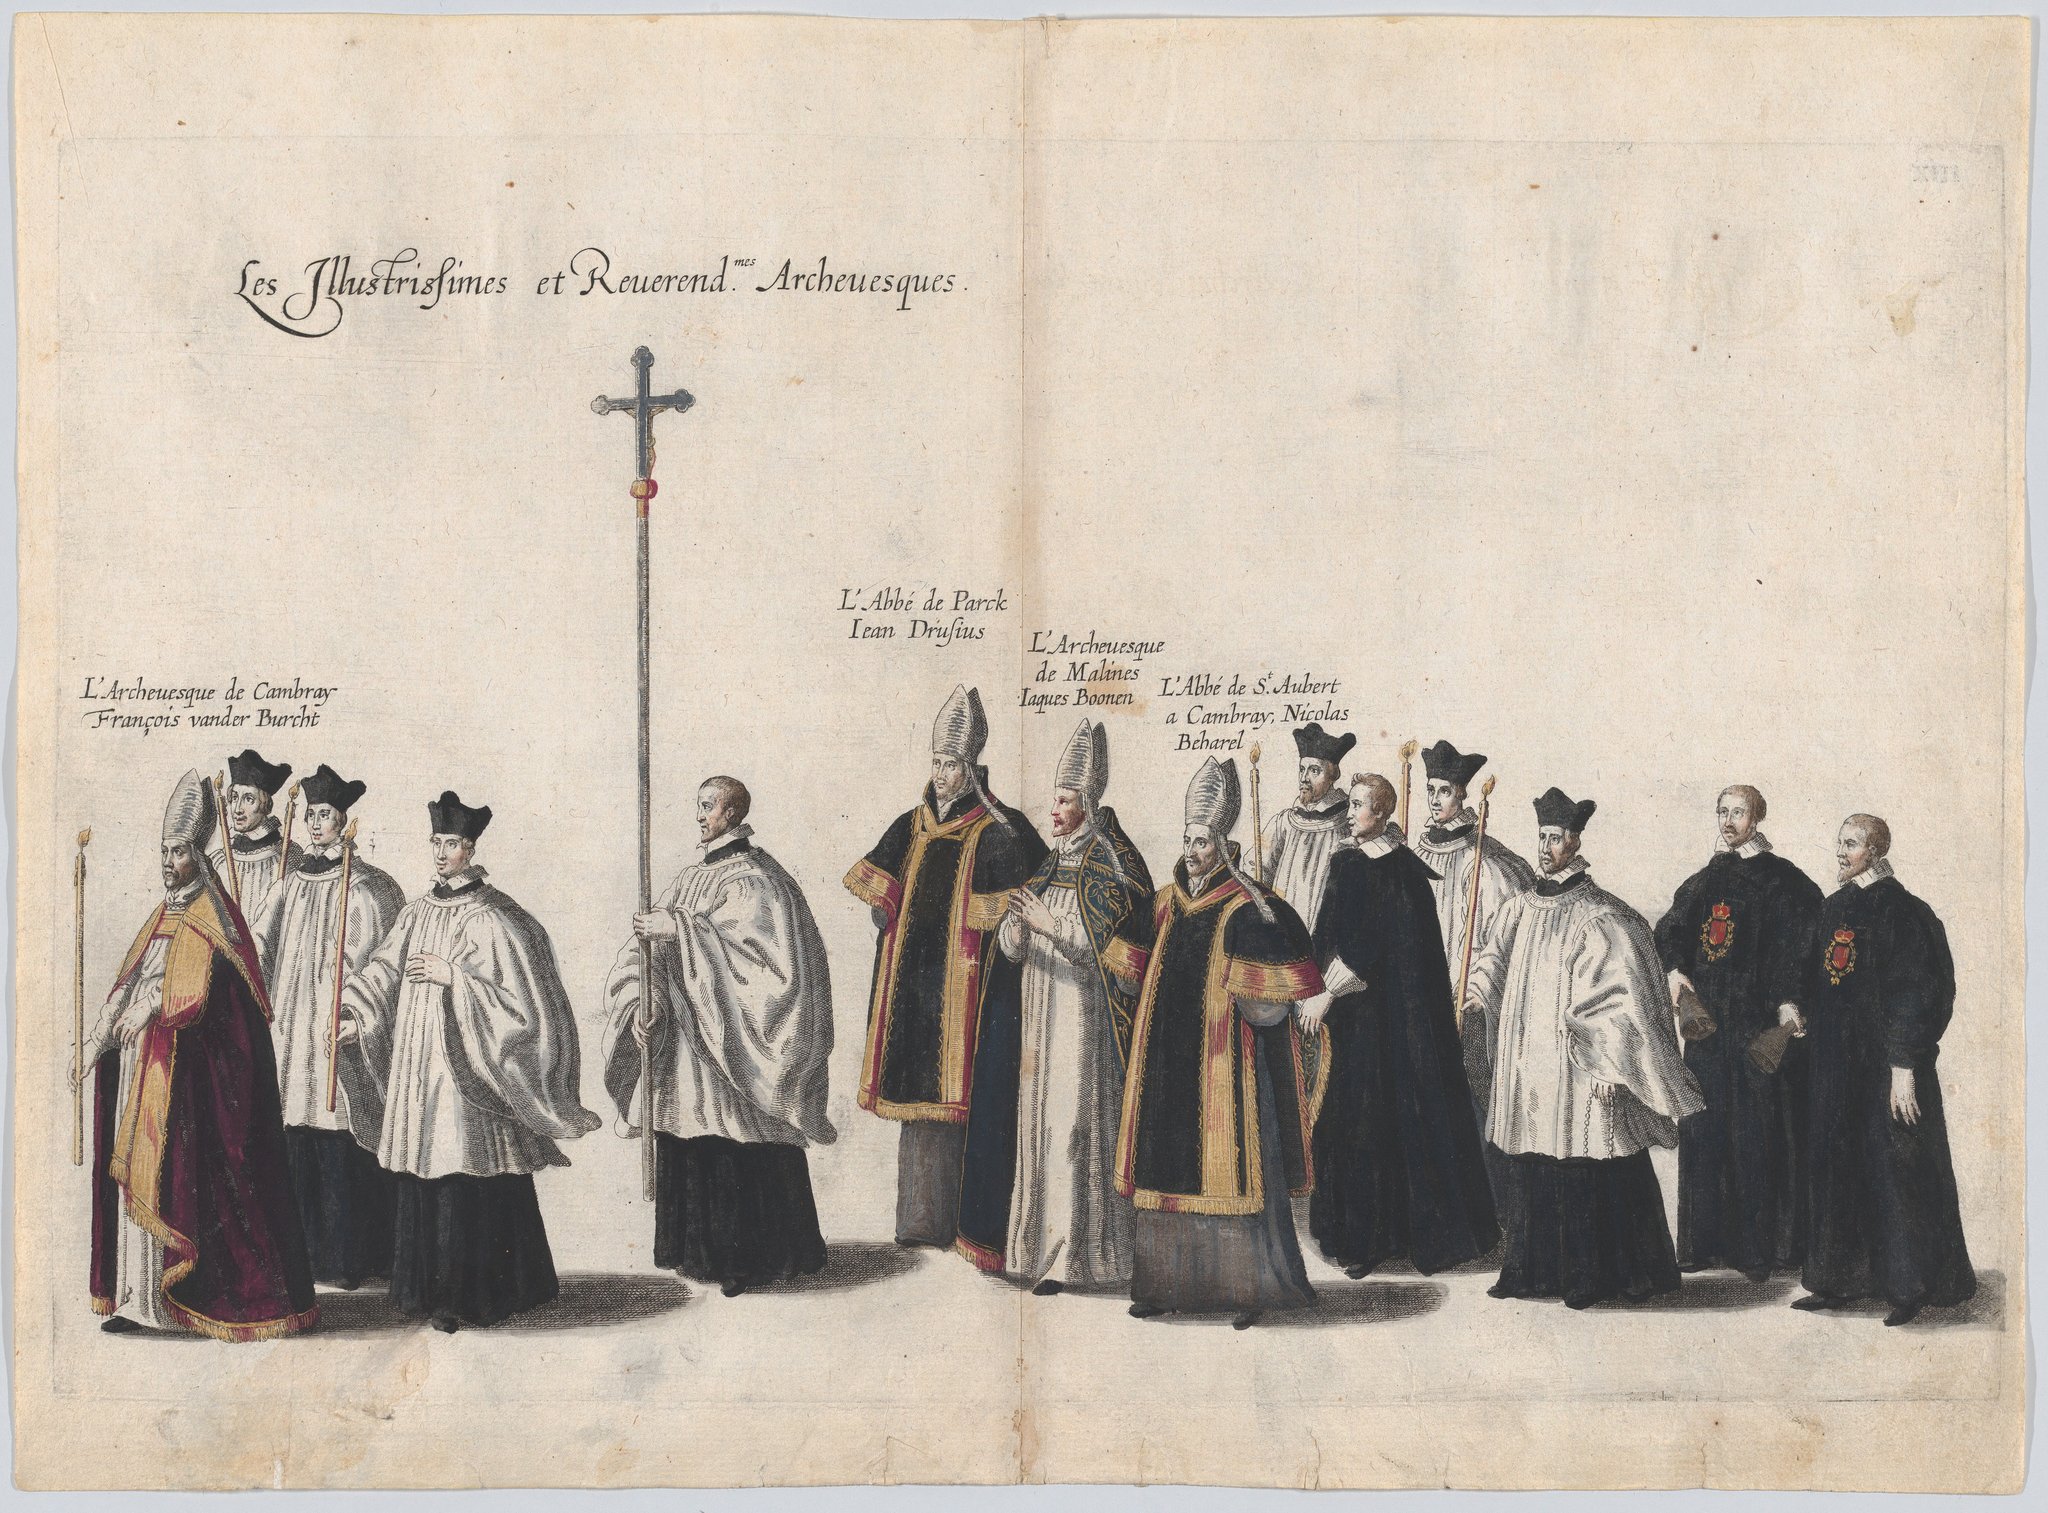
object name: print, fete, ornament architecture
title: Plate 13: Members of the clergy marching in the funeral procession of Archduke Albert of Austria; from 'Pompa Funebris ... Alberti Pii'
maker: cornelis galle (i)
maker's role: artist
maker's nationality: netherlandish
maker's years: 1576-1650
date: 1623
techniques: etching, hand coloring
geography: brussels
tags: men,cross,funerals,processions